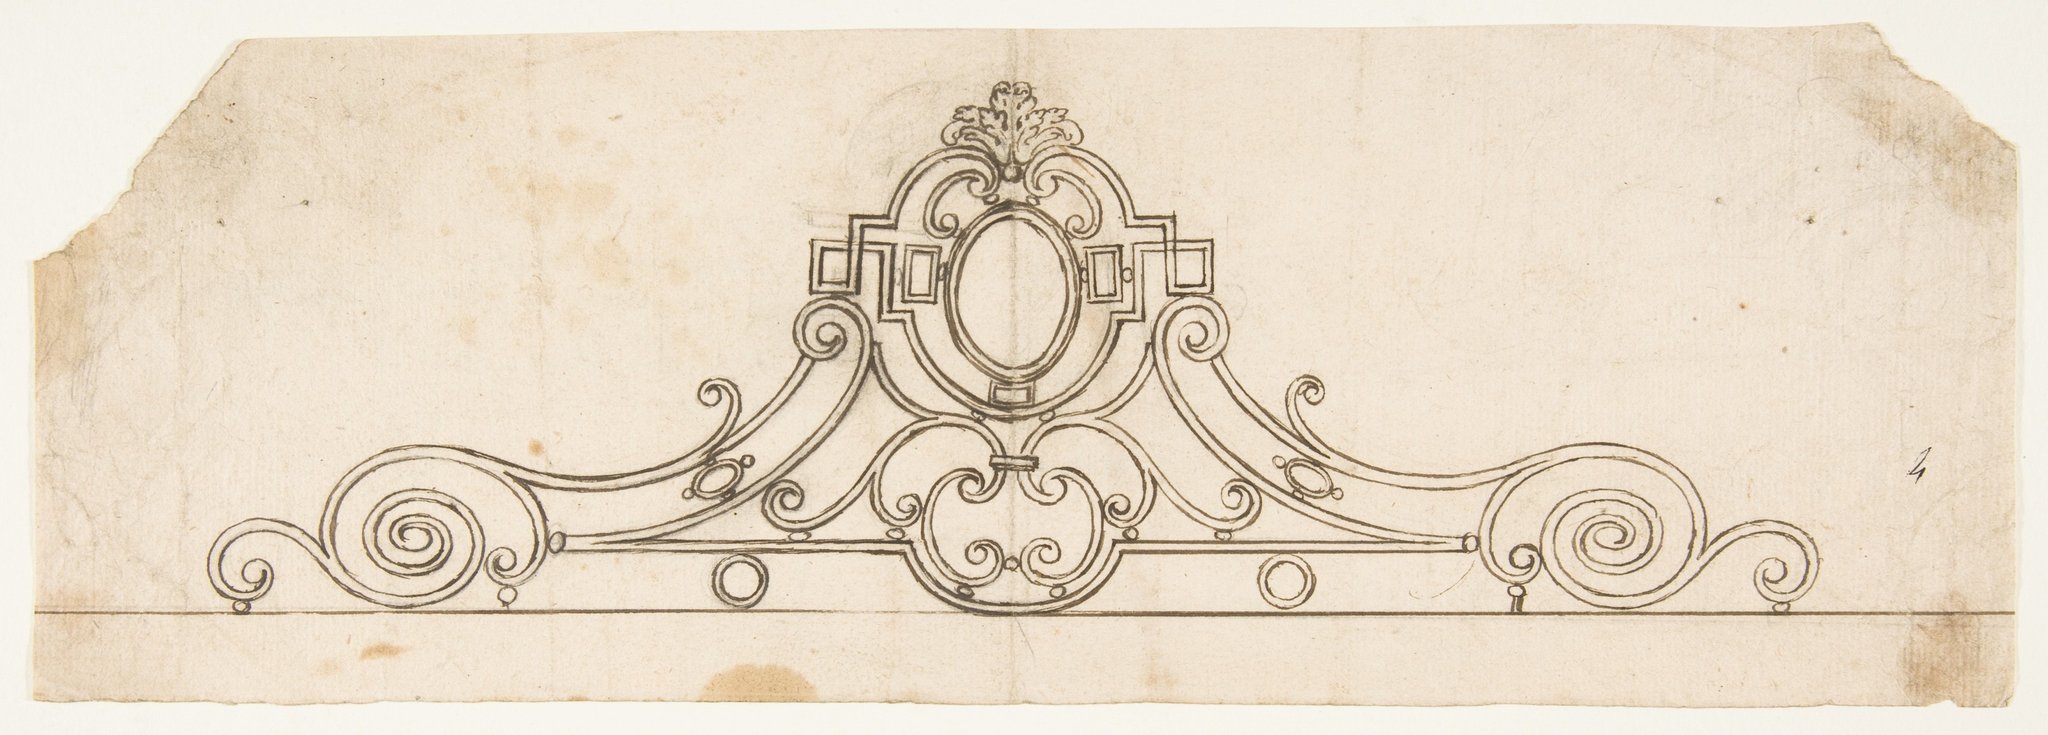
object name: drawing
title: Motif for an Iron Balcony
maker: anonymous, french, 19th century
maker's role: artist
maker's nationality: french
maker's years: 1800-1900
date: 1801-1900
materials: ink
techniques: pen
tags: ornament